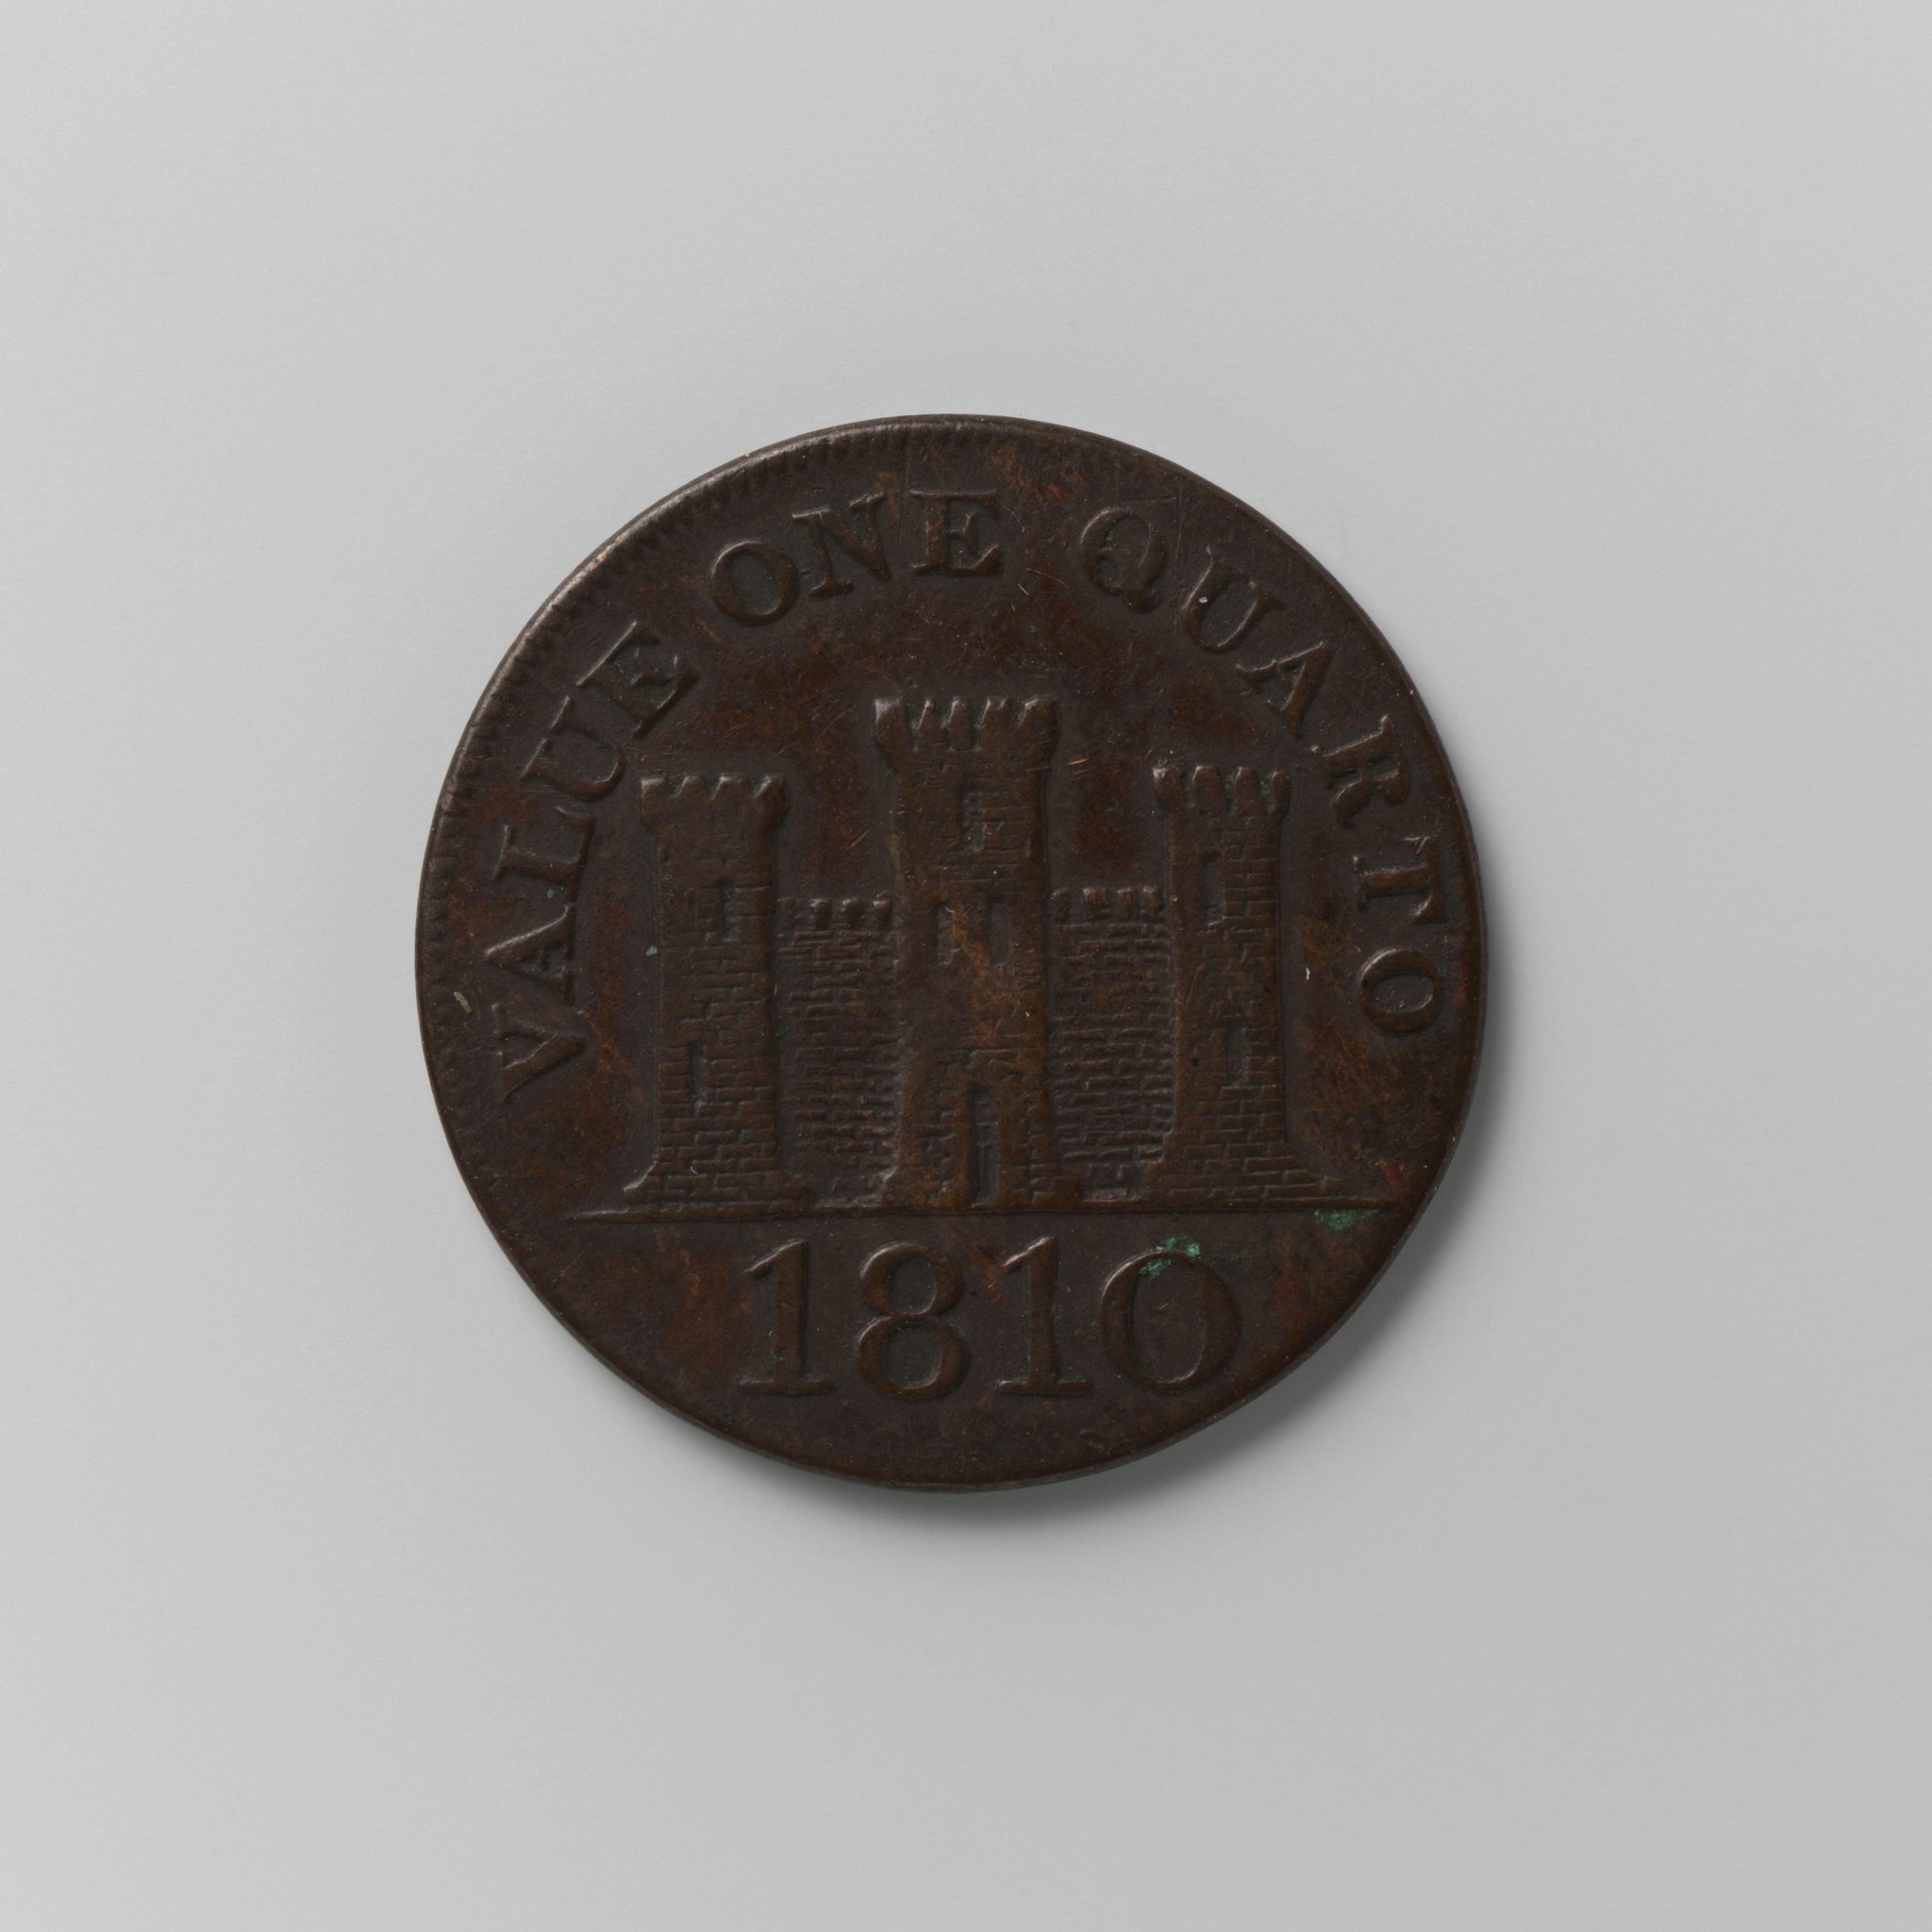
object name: coin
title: Gibraltar, quarto, 1810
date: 1810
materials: copper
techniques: striking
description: Koperen particuliere munt. Voorzijde: zittende leeuw naar links, in rechterklauw sleutel. Keerzijde: kasteel, waaronder jaartal. Waarde-aanduiding in omschrft. Gladde rand.